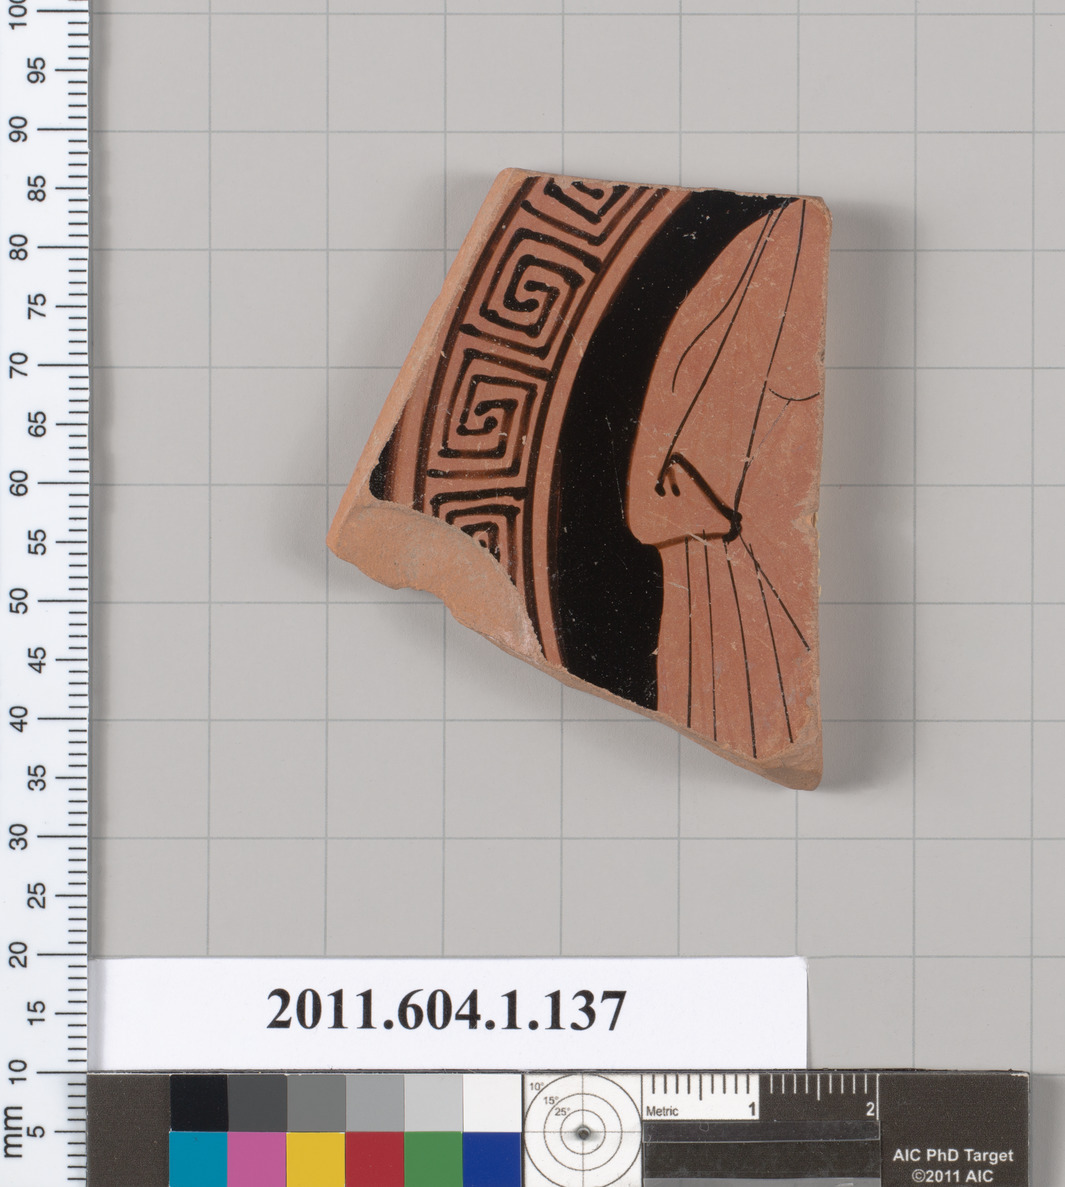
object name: kylix fragment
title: Terracotta fragment of a kylix (drinking cup)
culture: greek, attic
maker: aberdeen painter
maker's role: artist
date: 475-451 BCE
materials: terracotta